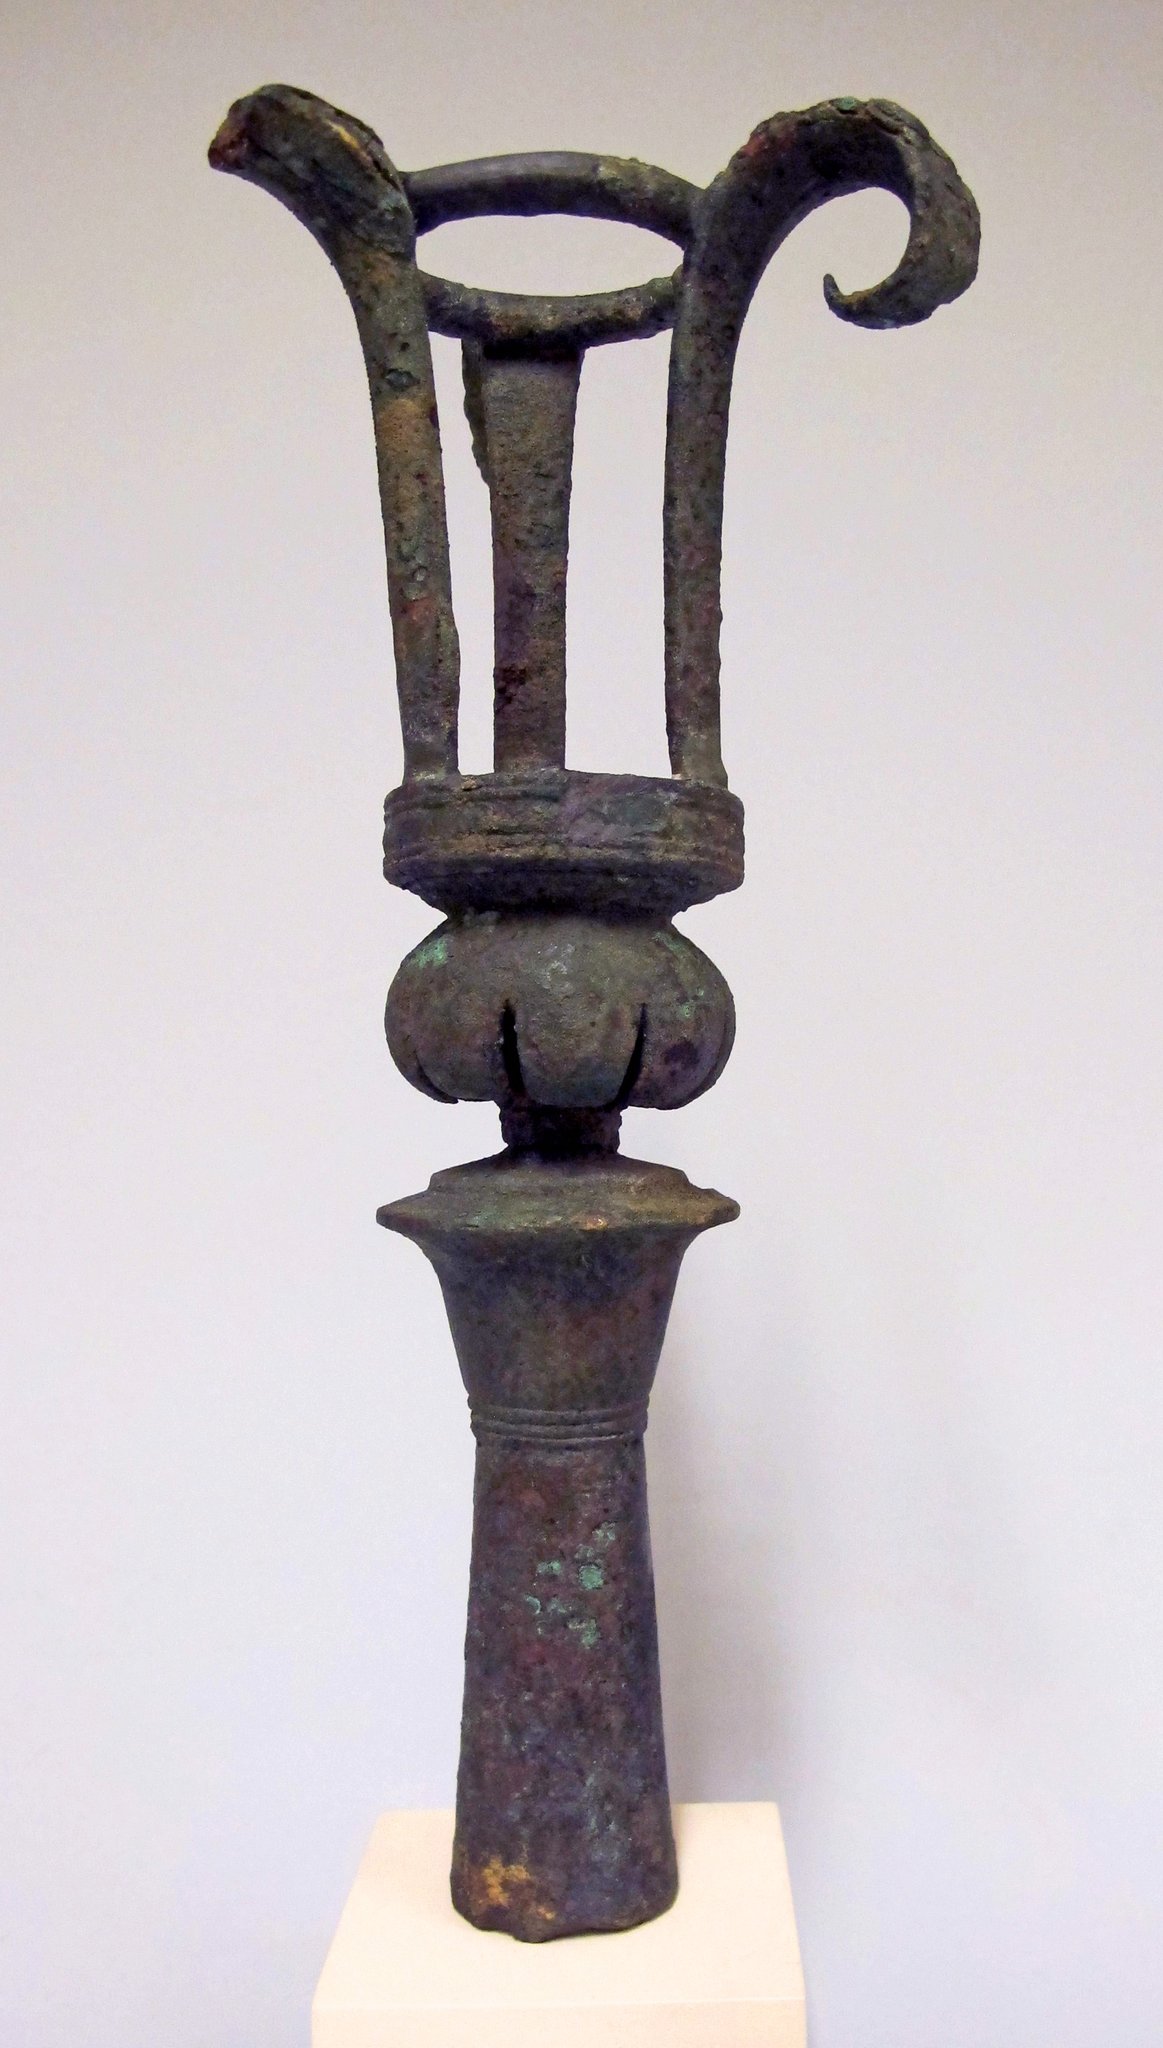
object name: lampstand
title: Bronze lampstand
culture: cypriot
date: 600-501 BCE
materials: bronze